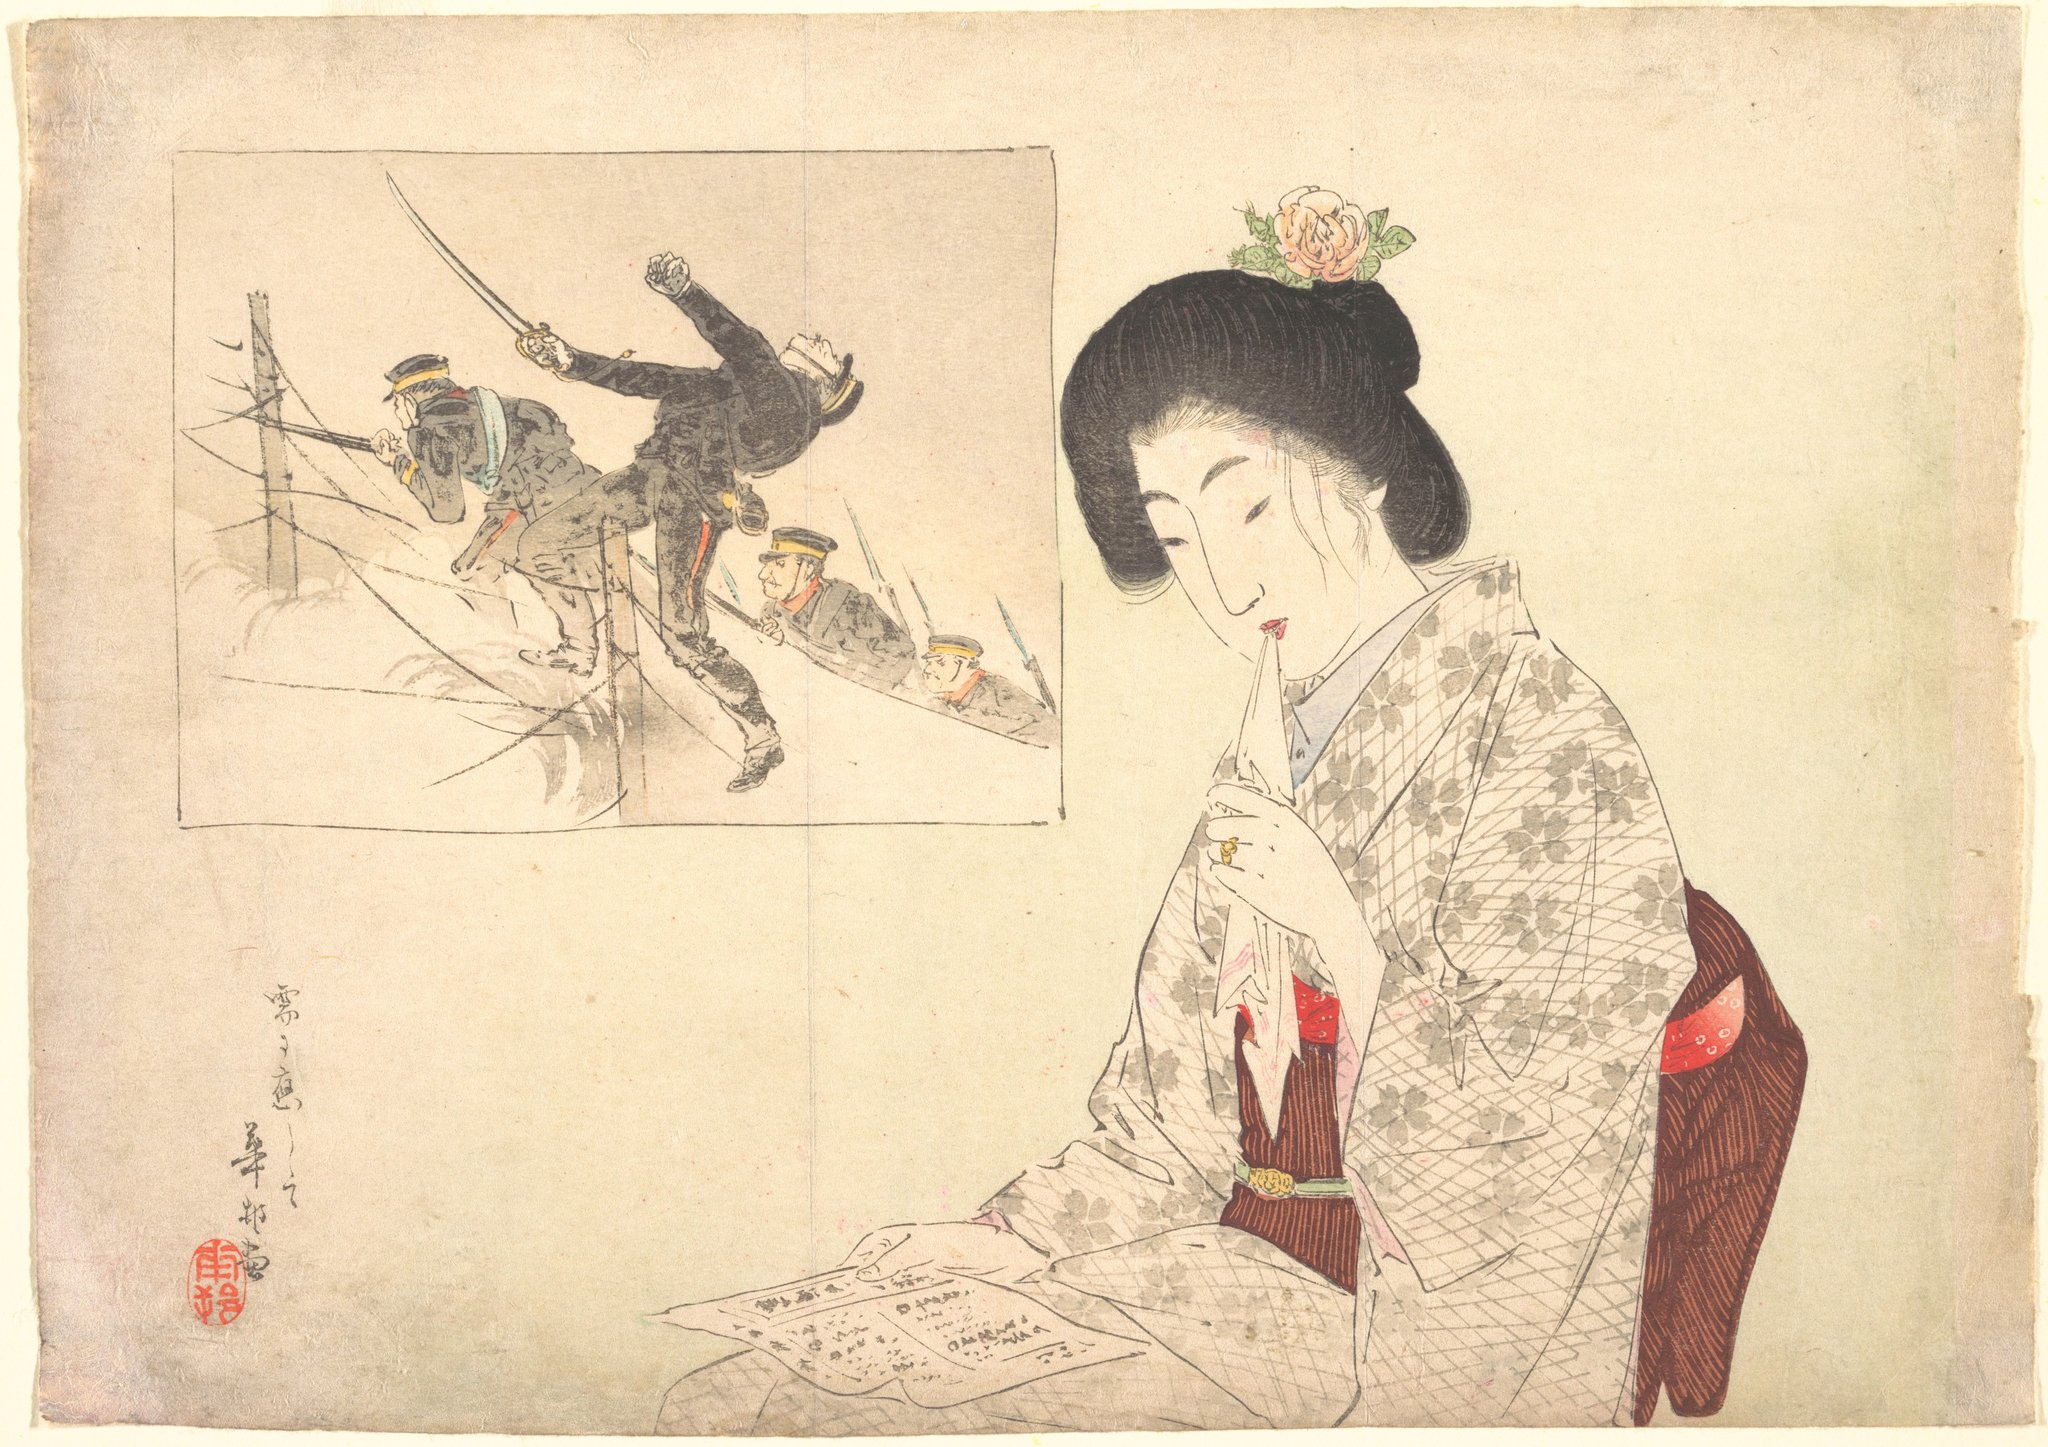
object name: print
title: Autumn Shower, Illustration from Bungei Kurabu (Literary Club)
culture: japanese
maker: suzuki kason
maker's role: artist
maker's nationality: japanese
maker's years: 1860-1919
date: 1904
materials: ink, paper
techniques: woodblock print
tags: soldiers,sadness,women,reading